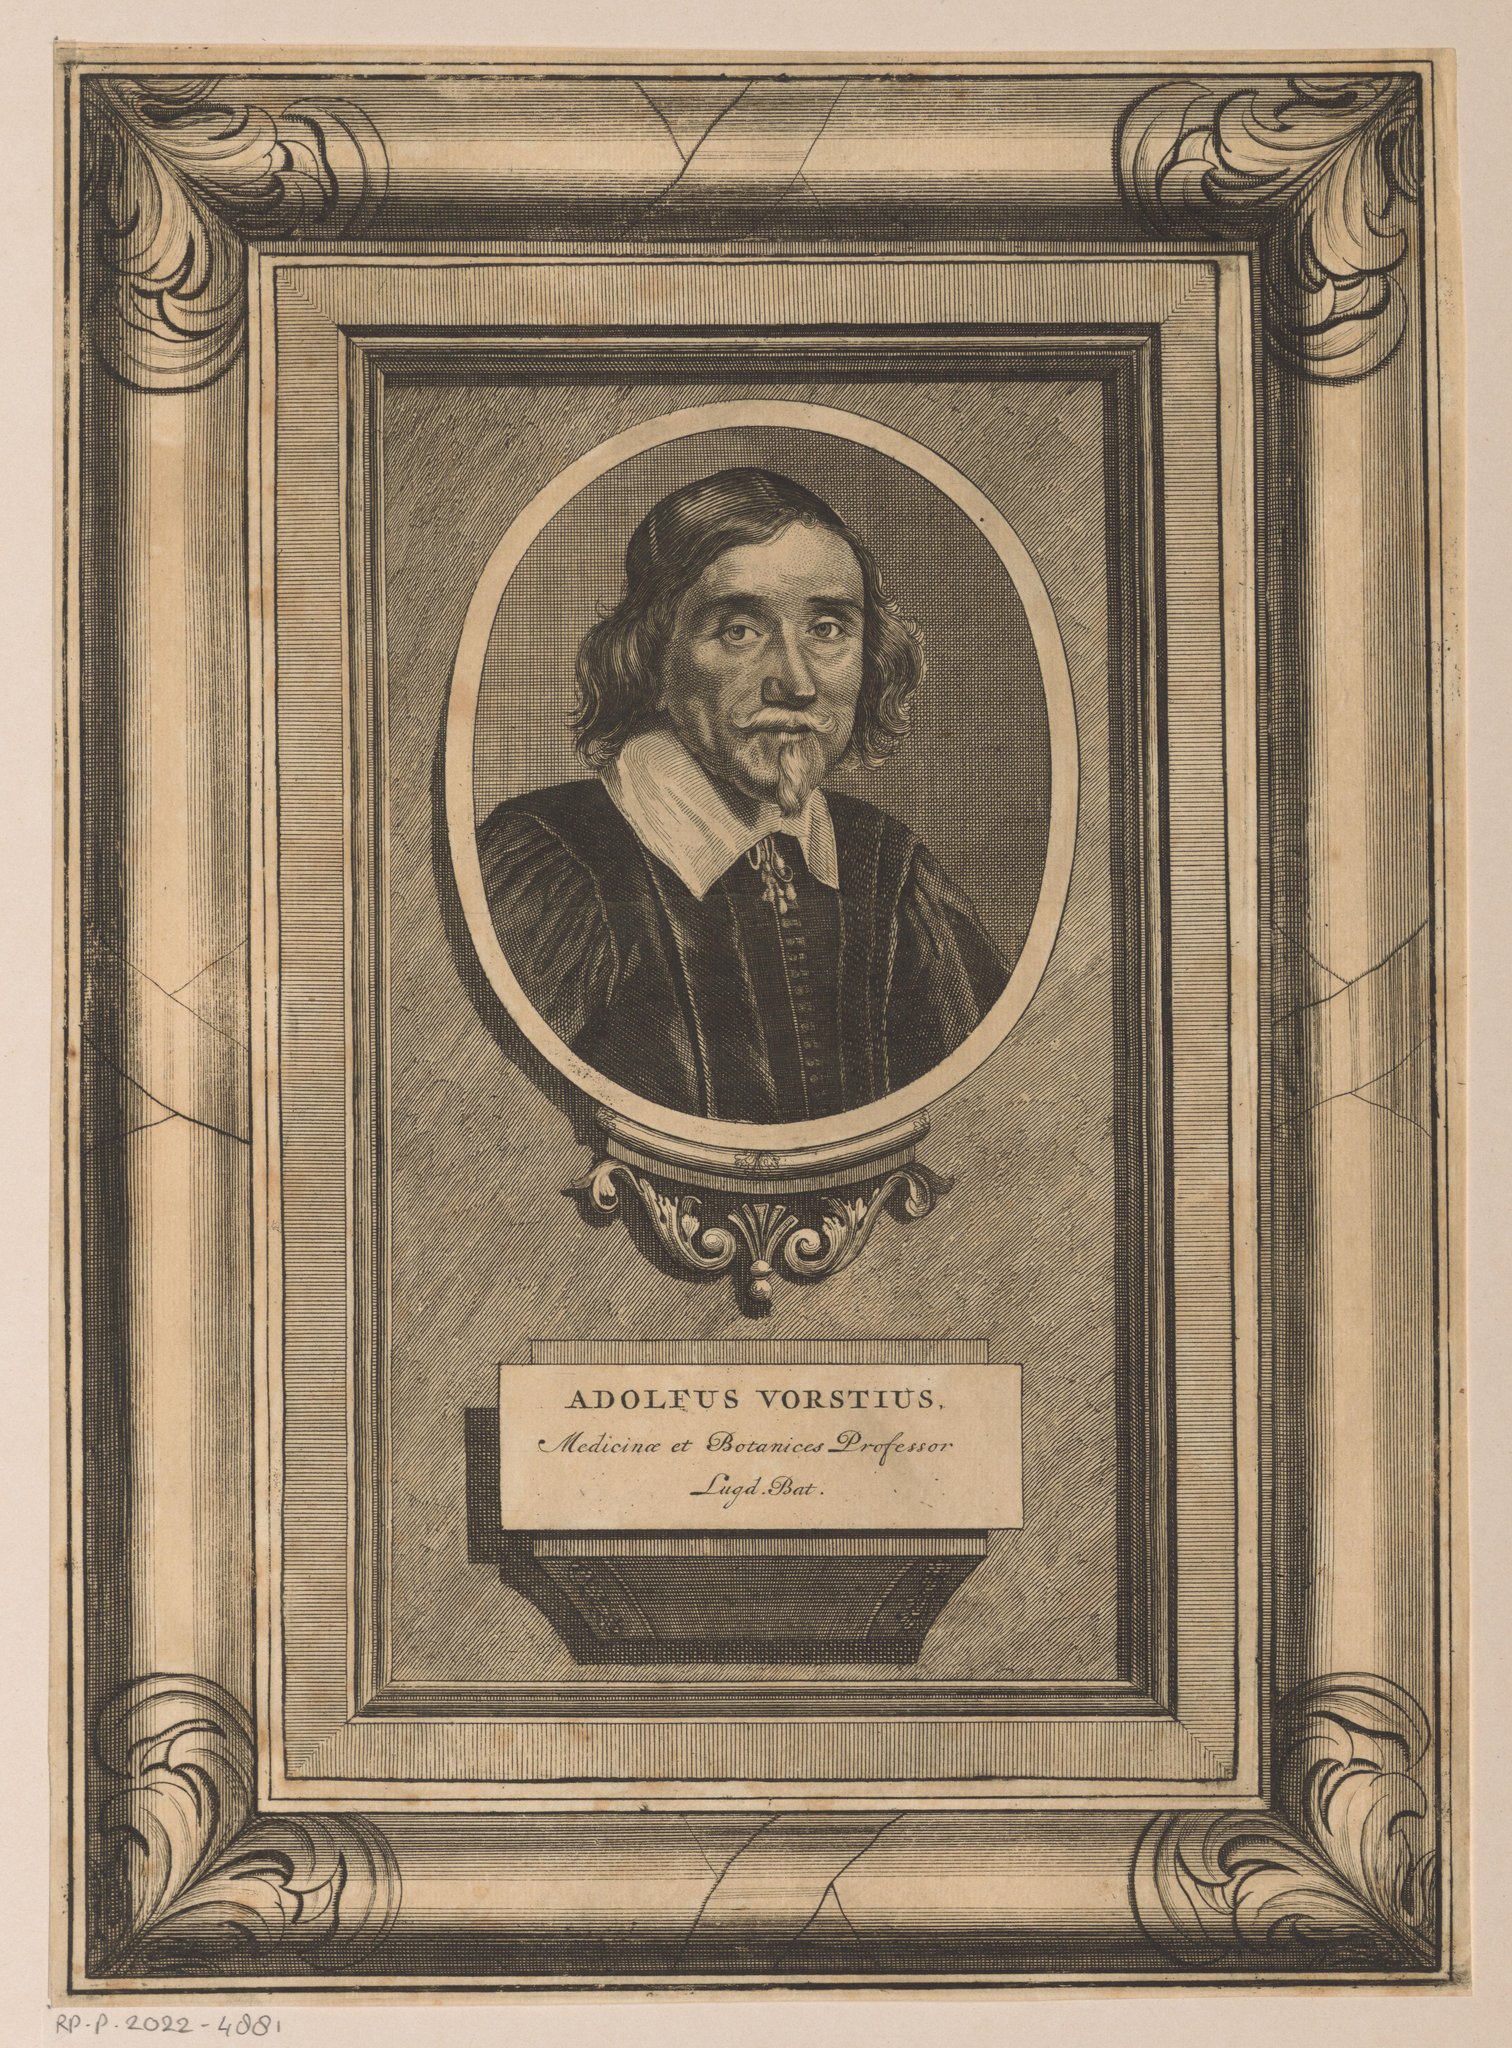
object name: print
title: Beroemde mannen aan de universiteit van Leiden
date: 1716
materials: paper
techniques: engraving, etching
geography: leiden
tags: delft, leiden, scholar, philosopher, historical persons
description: Met omlijsting gedrukt van een aparte plaat.